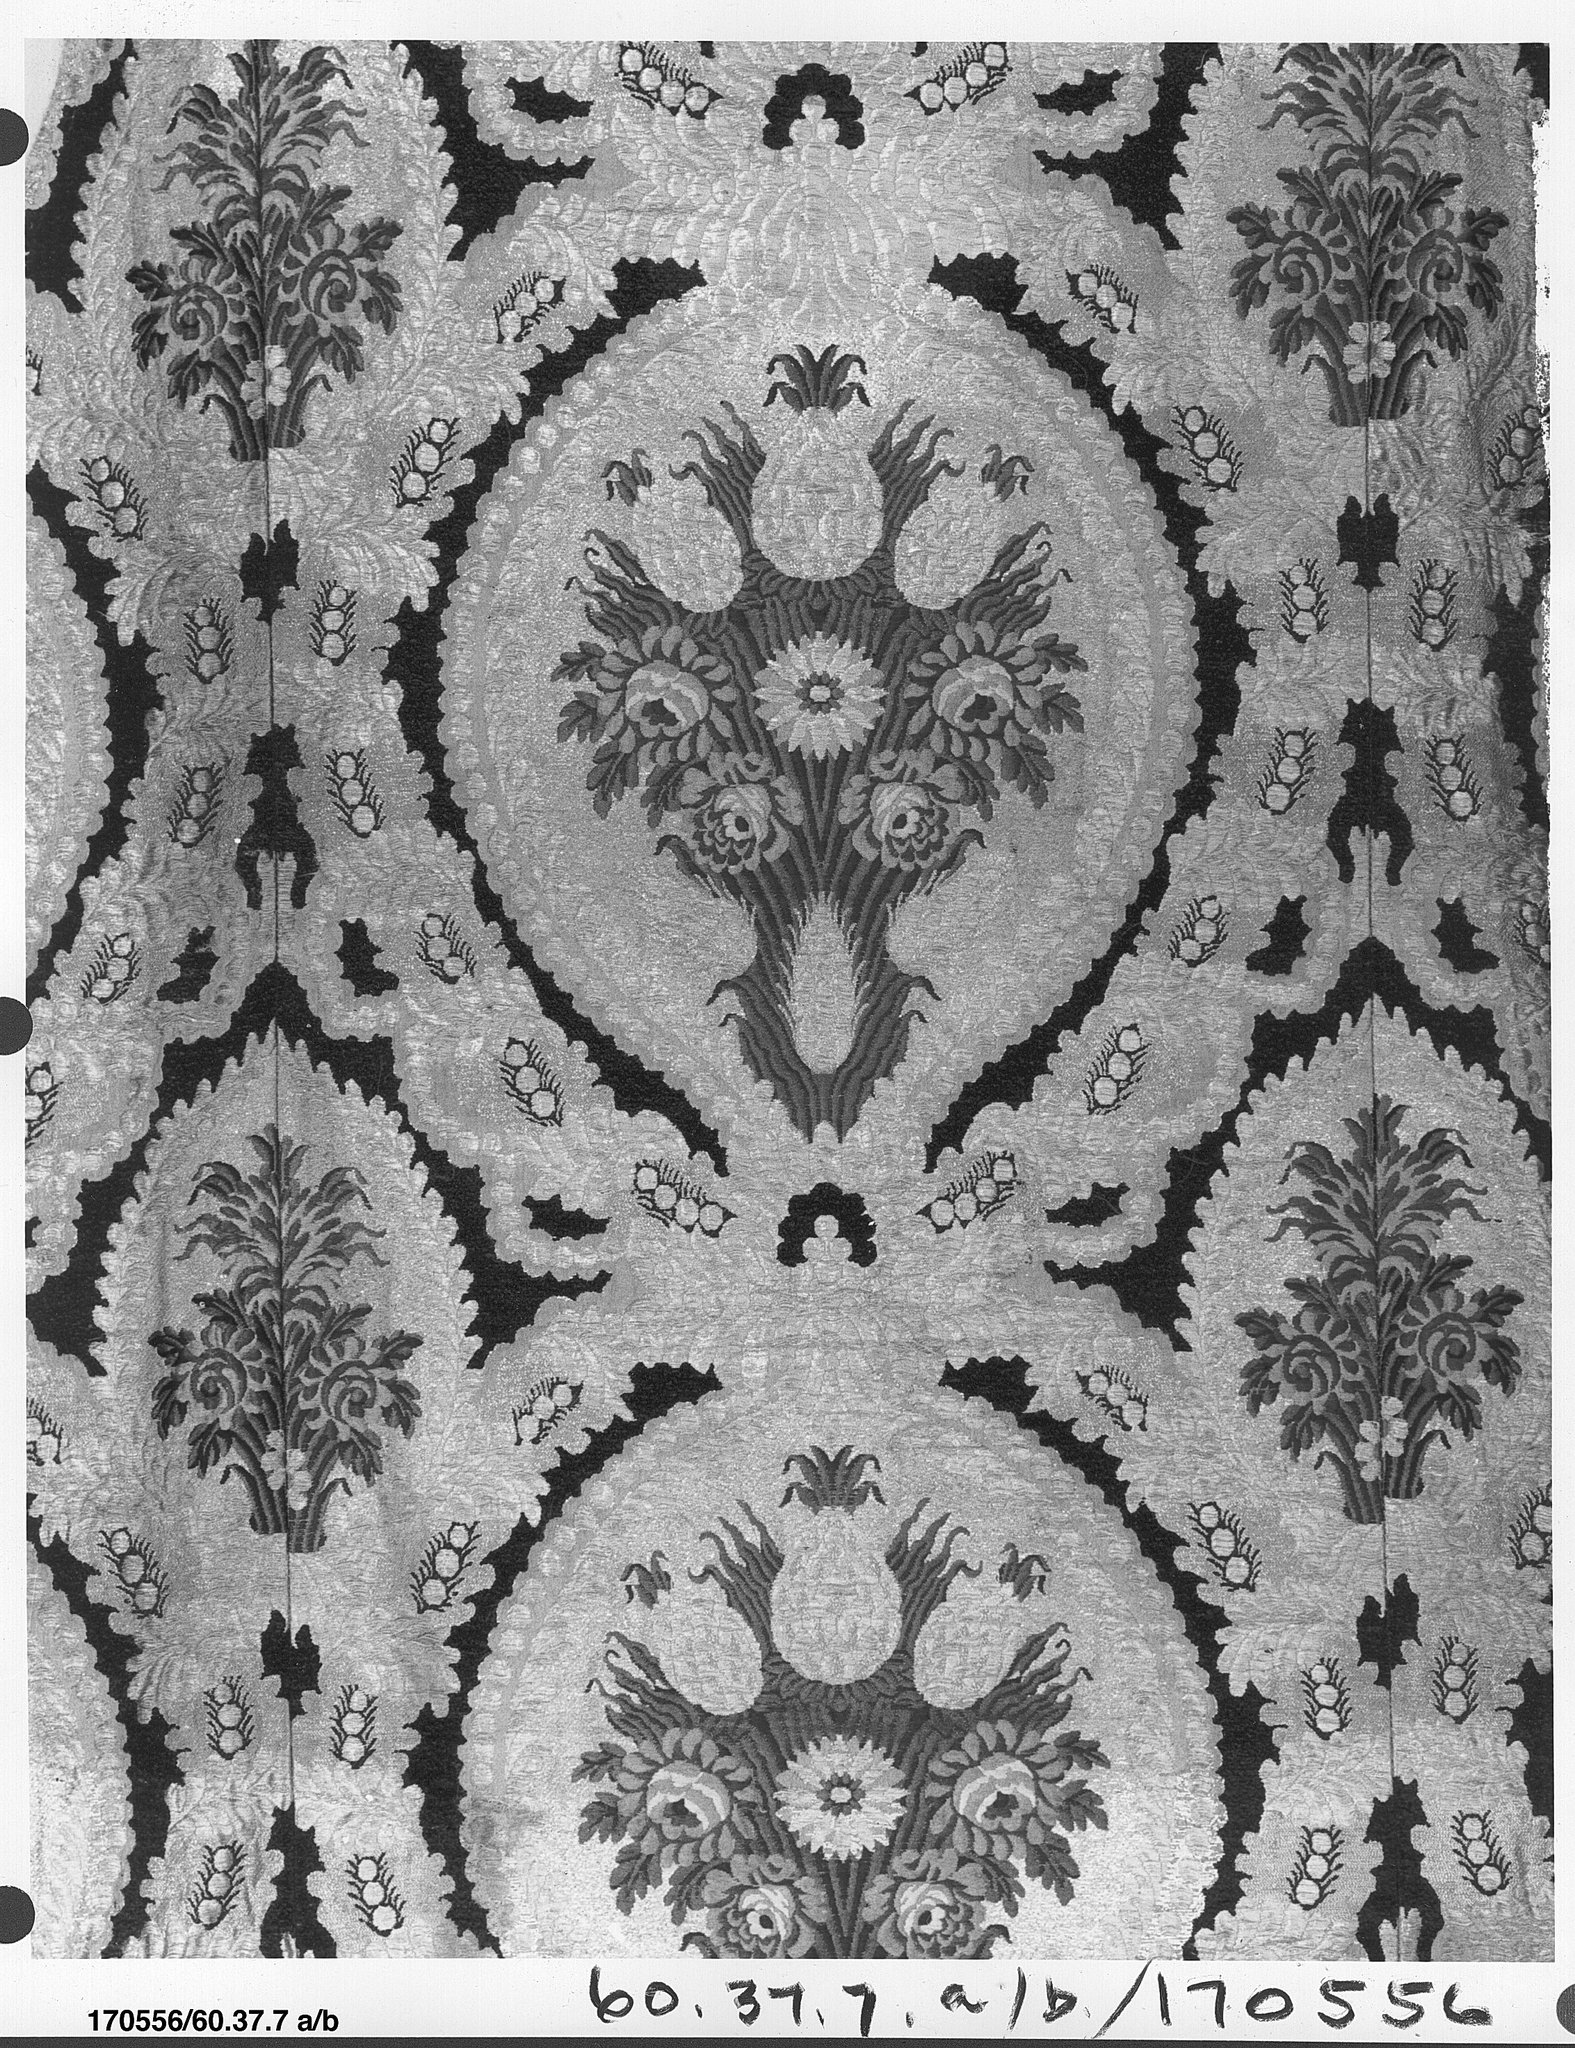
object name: piece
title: Pieces (2)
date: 1801-1900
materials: metal thread, silk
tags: flowers